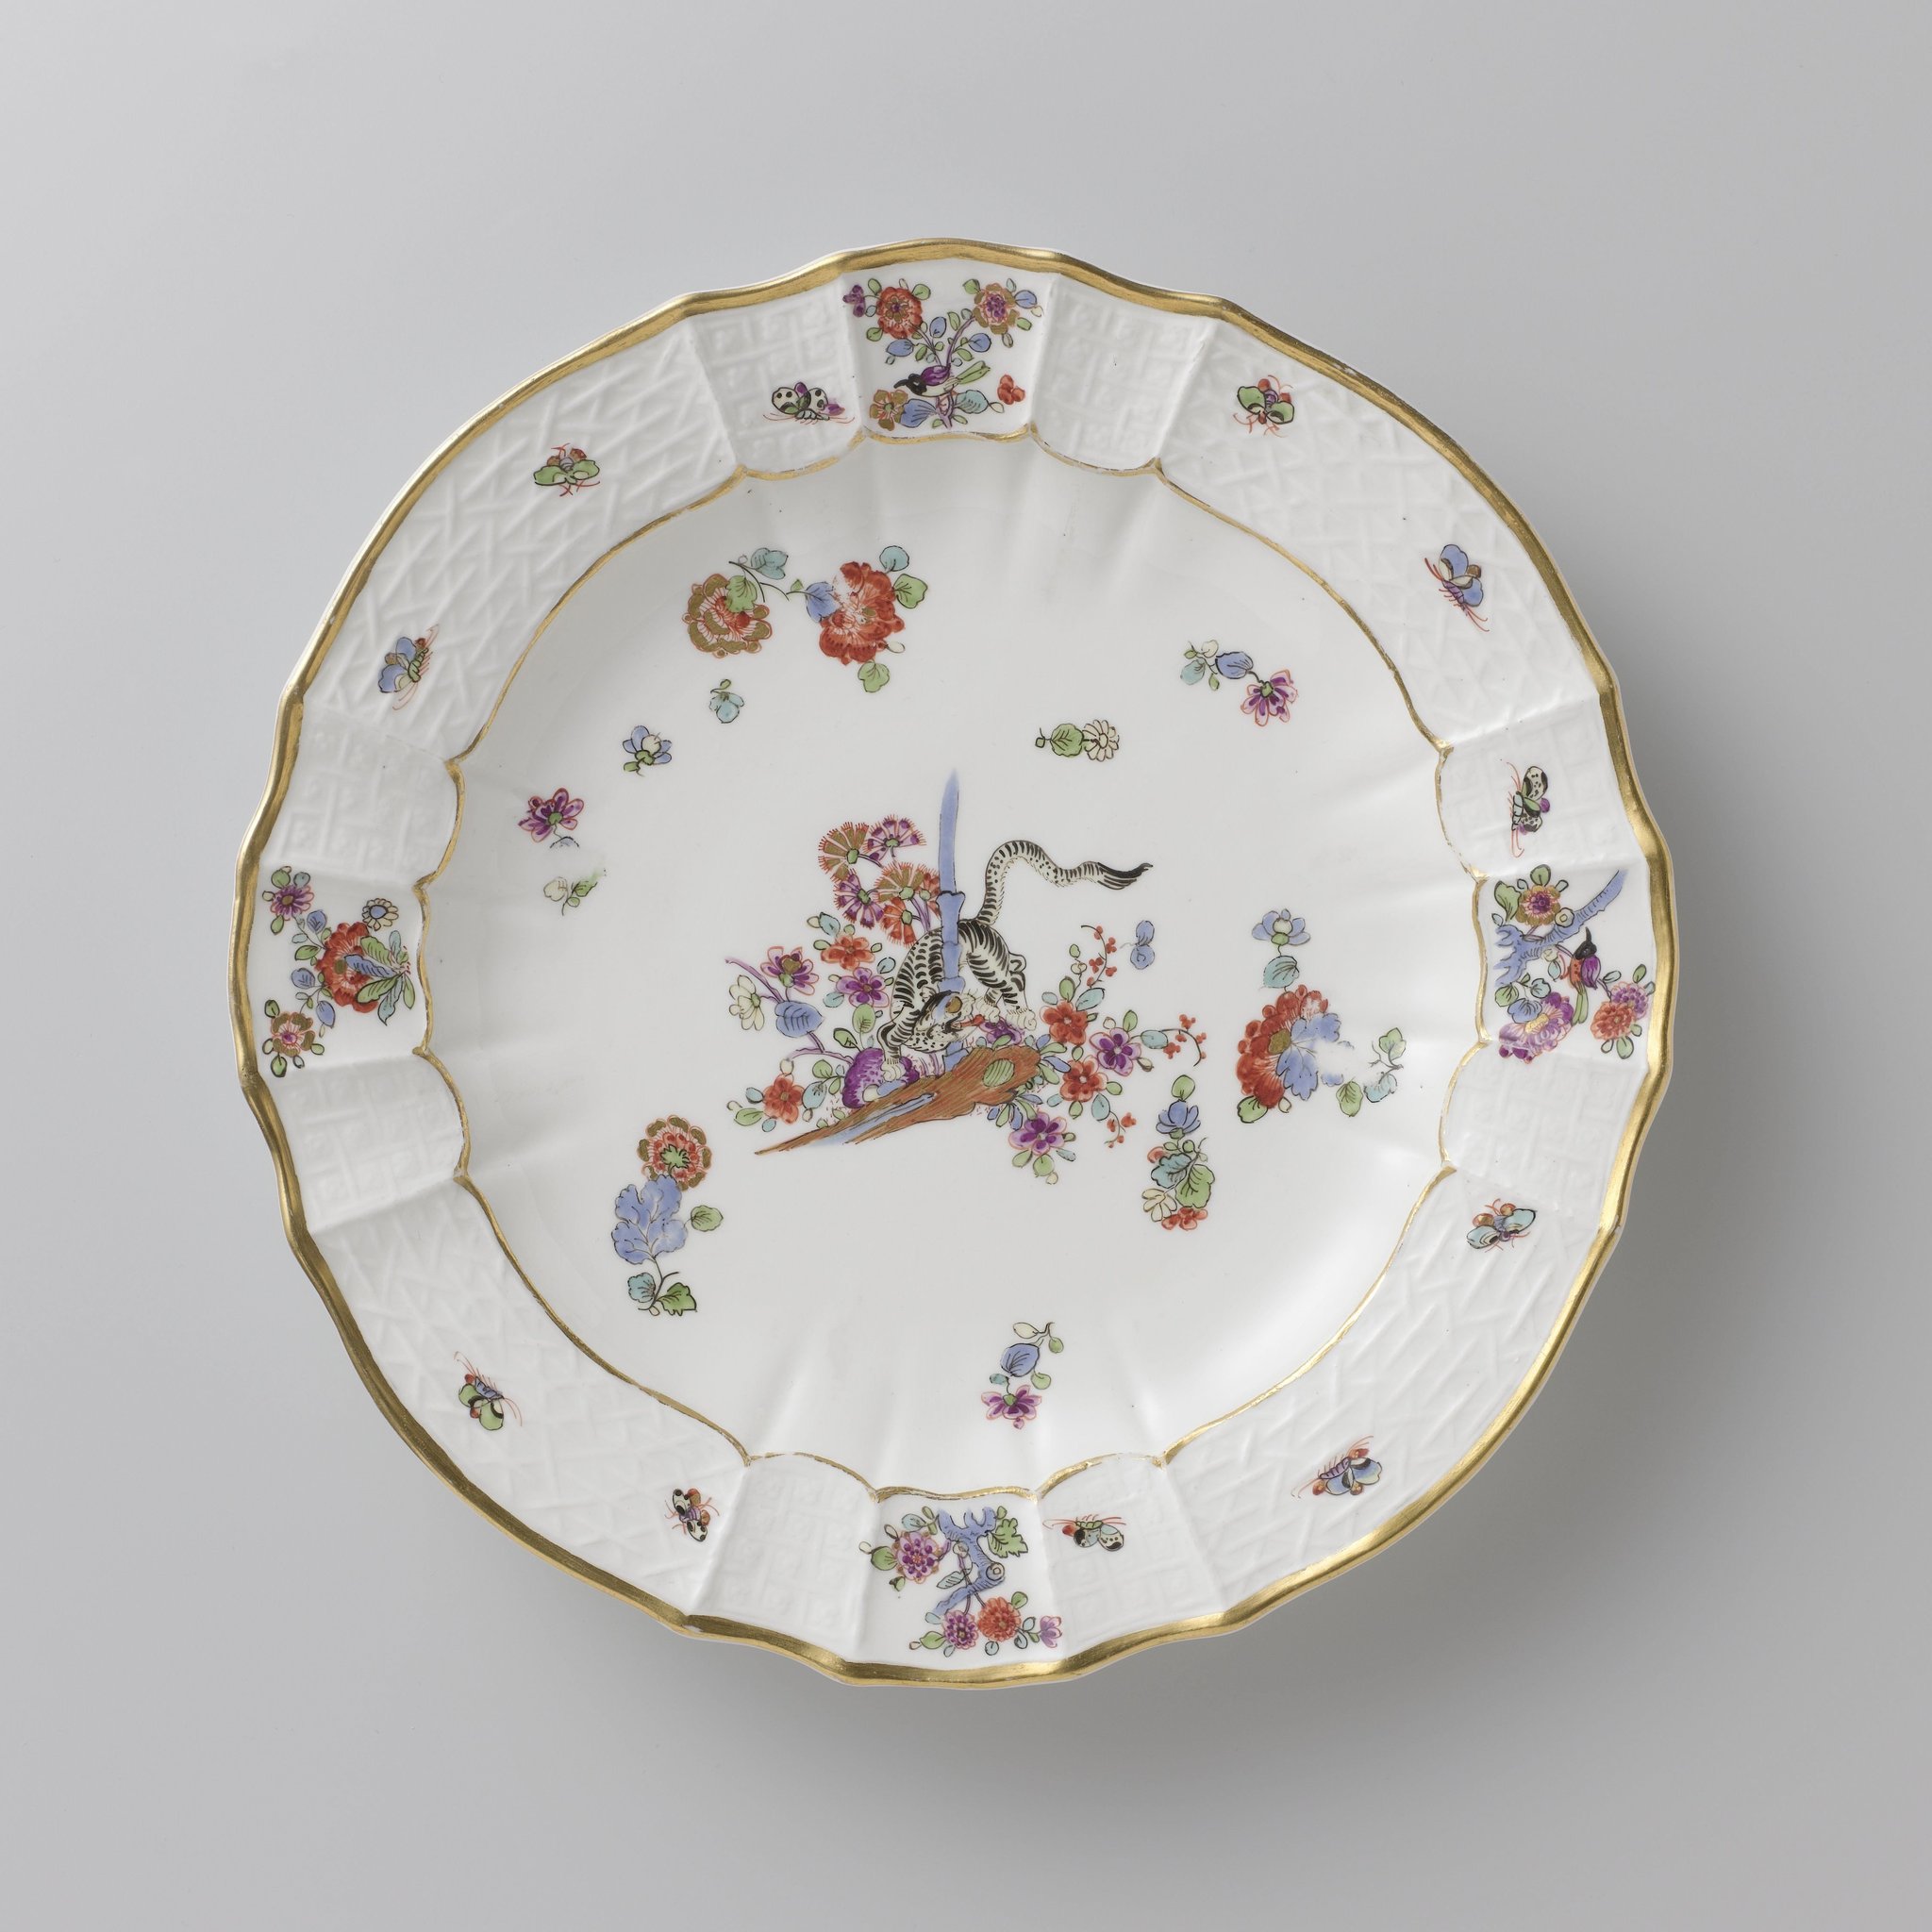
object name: plate dish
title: Rond bord, veelkleurig beschilderd met een Kakiemon-decor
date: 1740-1745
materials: porcelain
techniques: painted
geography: meissen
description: Rond bord van beschilderd porselein. Het bord is geribd en heeft een geschulpte rand. Het bord is beschilderd met een tijger die om een blauwe bamboestengel tussen bloemen is gedraaid, gestrooide Indianische Blumen, vlinders en takken waarop vogels. De rand is versierd met het 'Altbrandenstein'-patroon. Het bord is gemerkt.